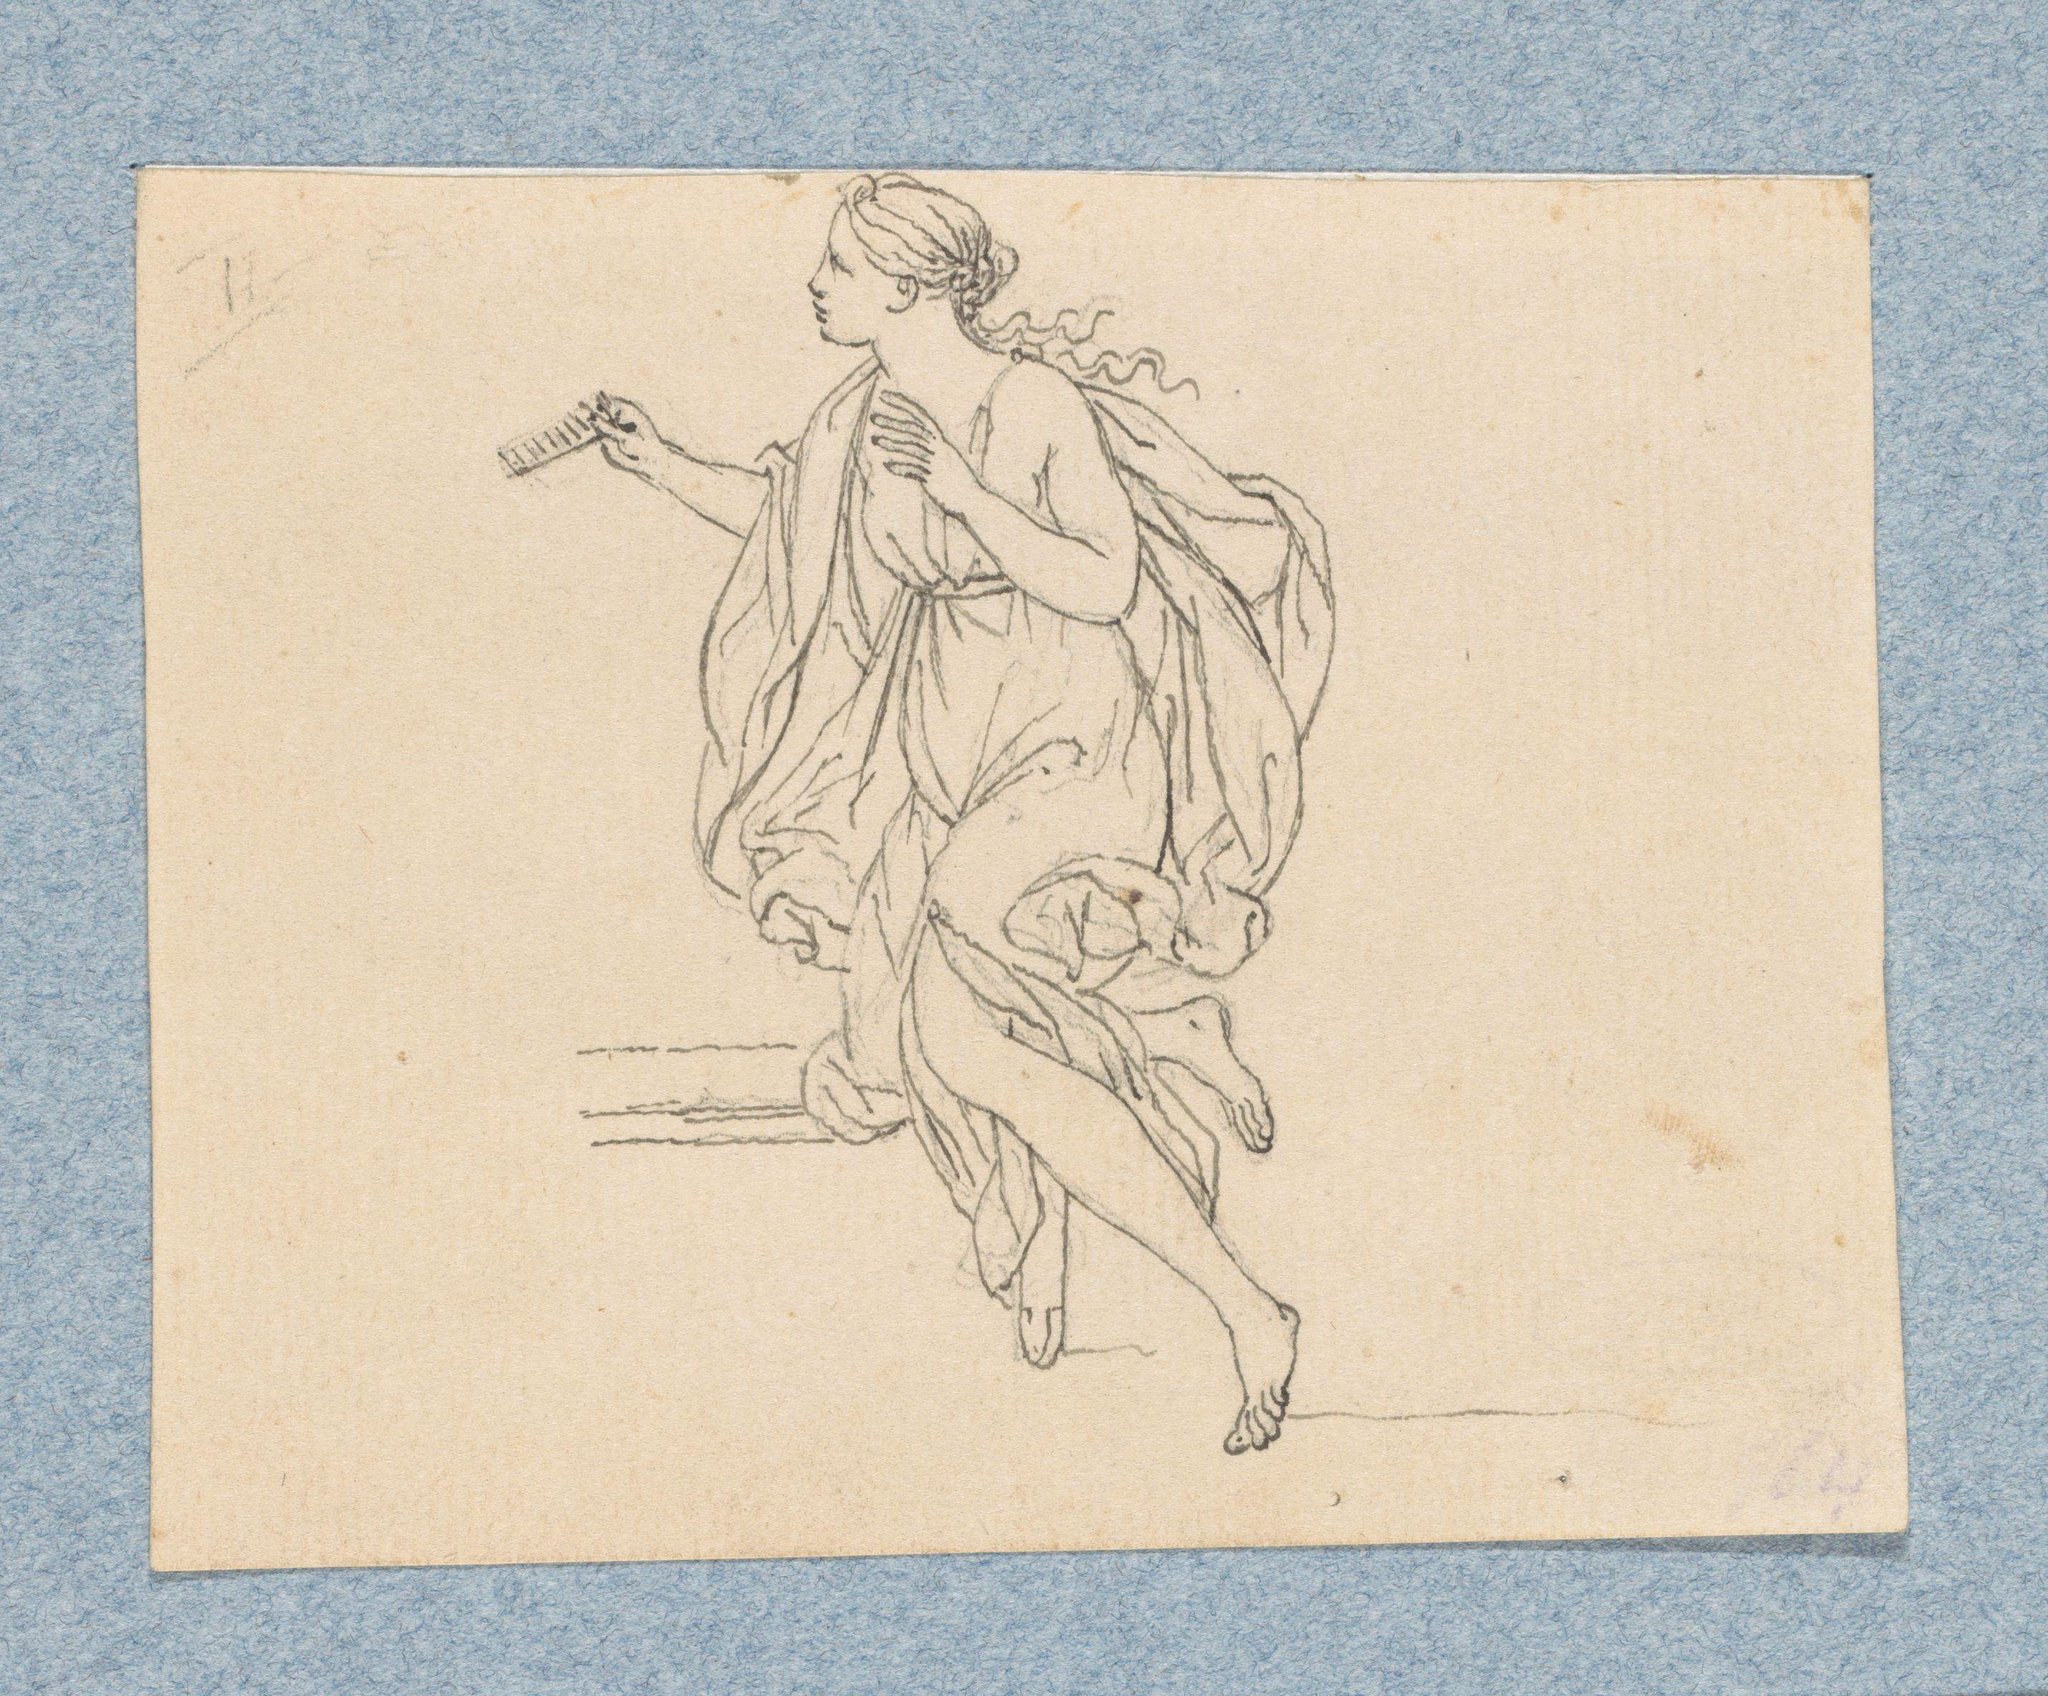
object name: drawing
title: Knielende vrouw met kam (in doos met 43 tekeningen)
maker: louis fabritius dubourg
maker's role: draughtsman, print maker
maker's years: 1693-1775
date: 1703-1775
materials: ink, paper, pencil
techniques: pen